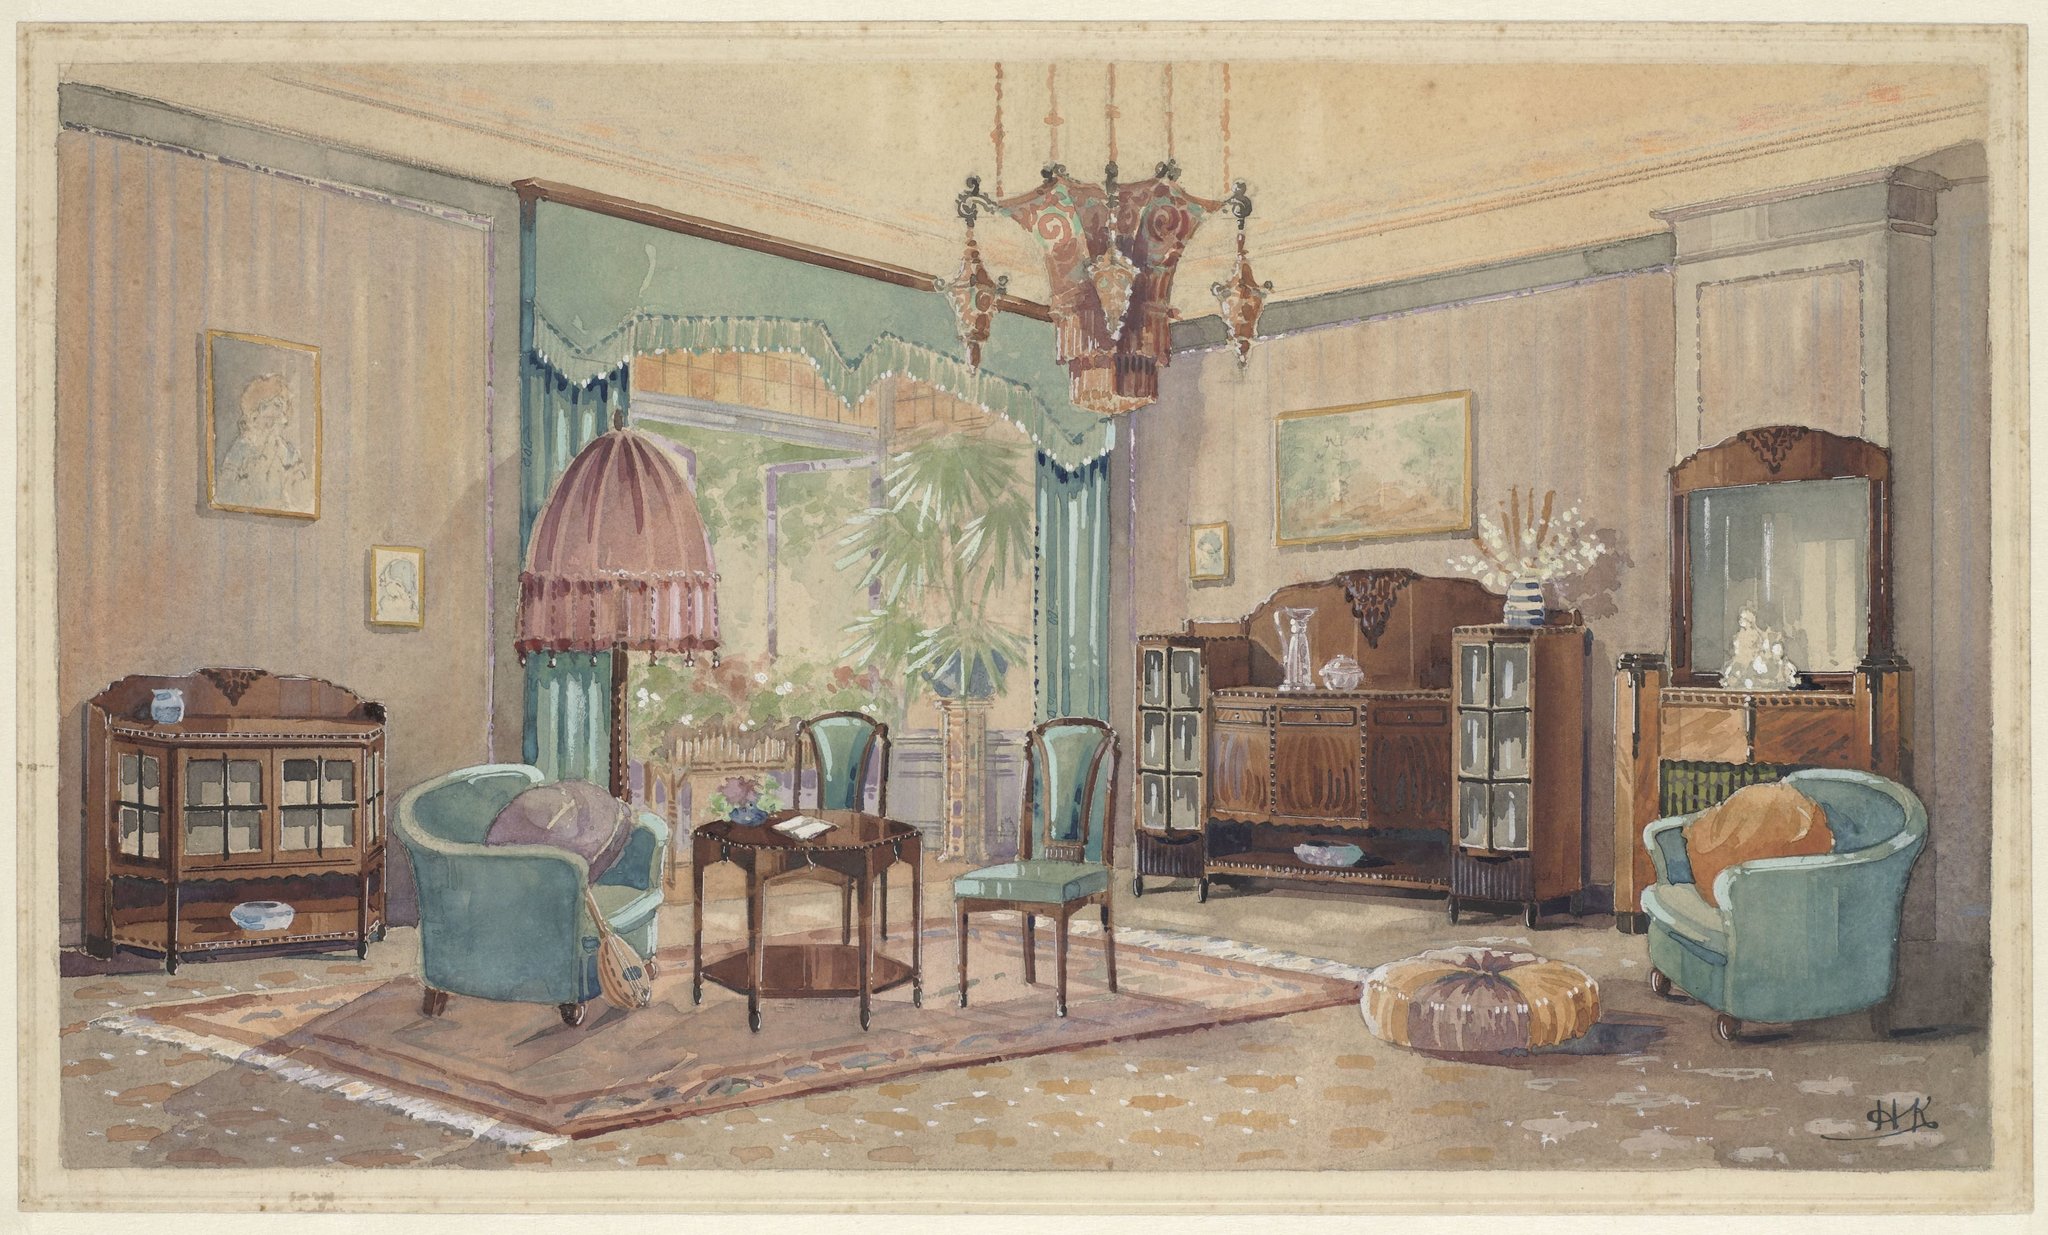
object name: watercolor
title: Zitkamer met palm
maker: monogrammist hk (nederland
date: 1925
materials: paper, watercolor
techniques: brush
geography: amsterdam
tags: drawing-room, 'salon'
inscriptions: monogram: ‘HK’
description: Mogelijk is dit een demonstratietekeningen van een meubel- of inrichtingszaak.